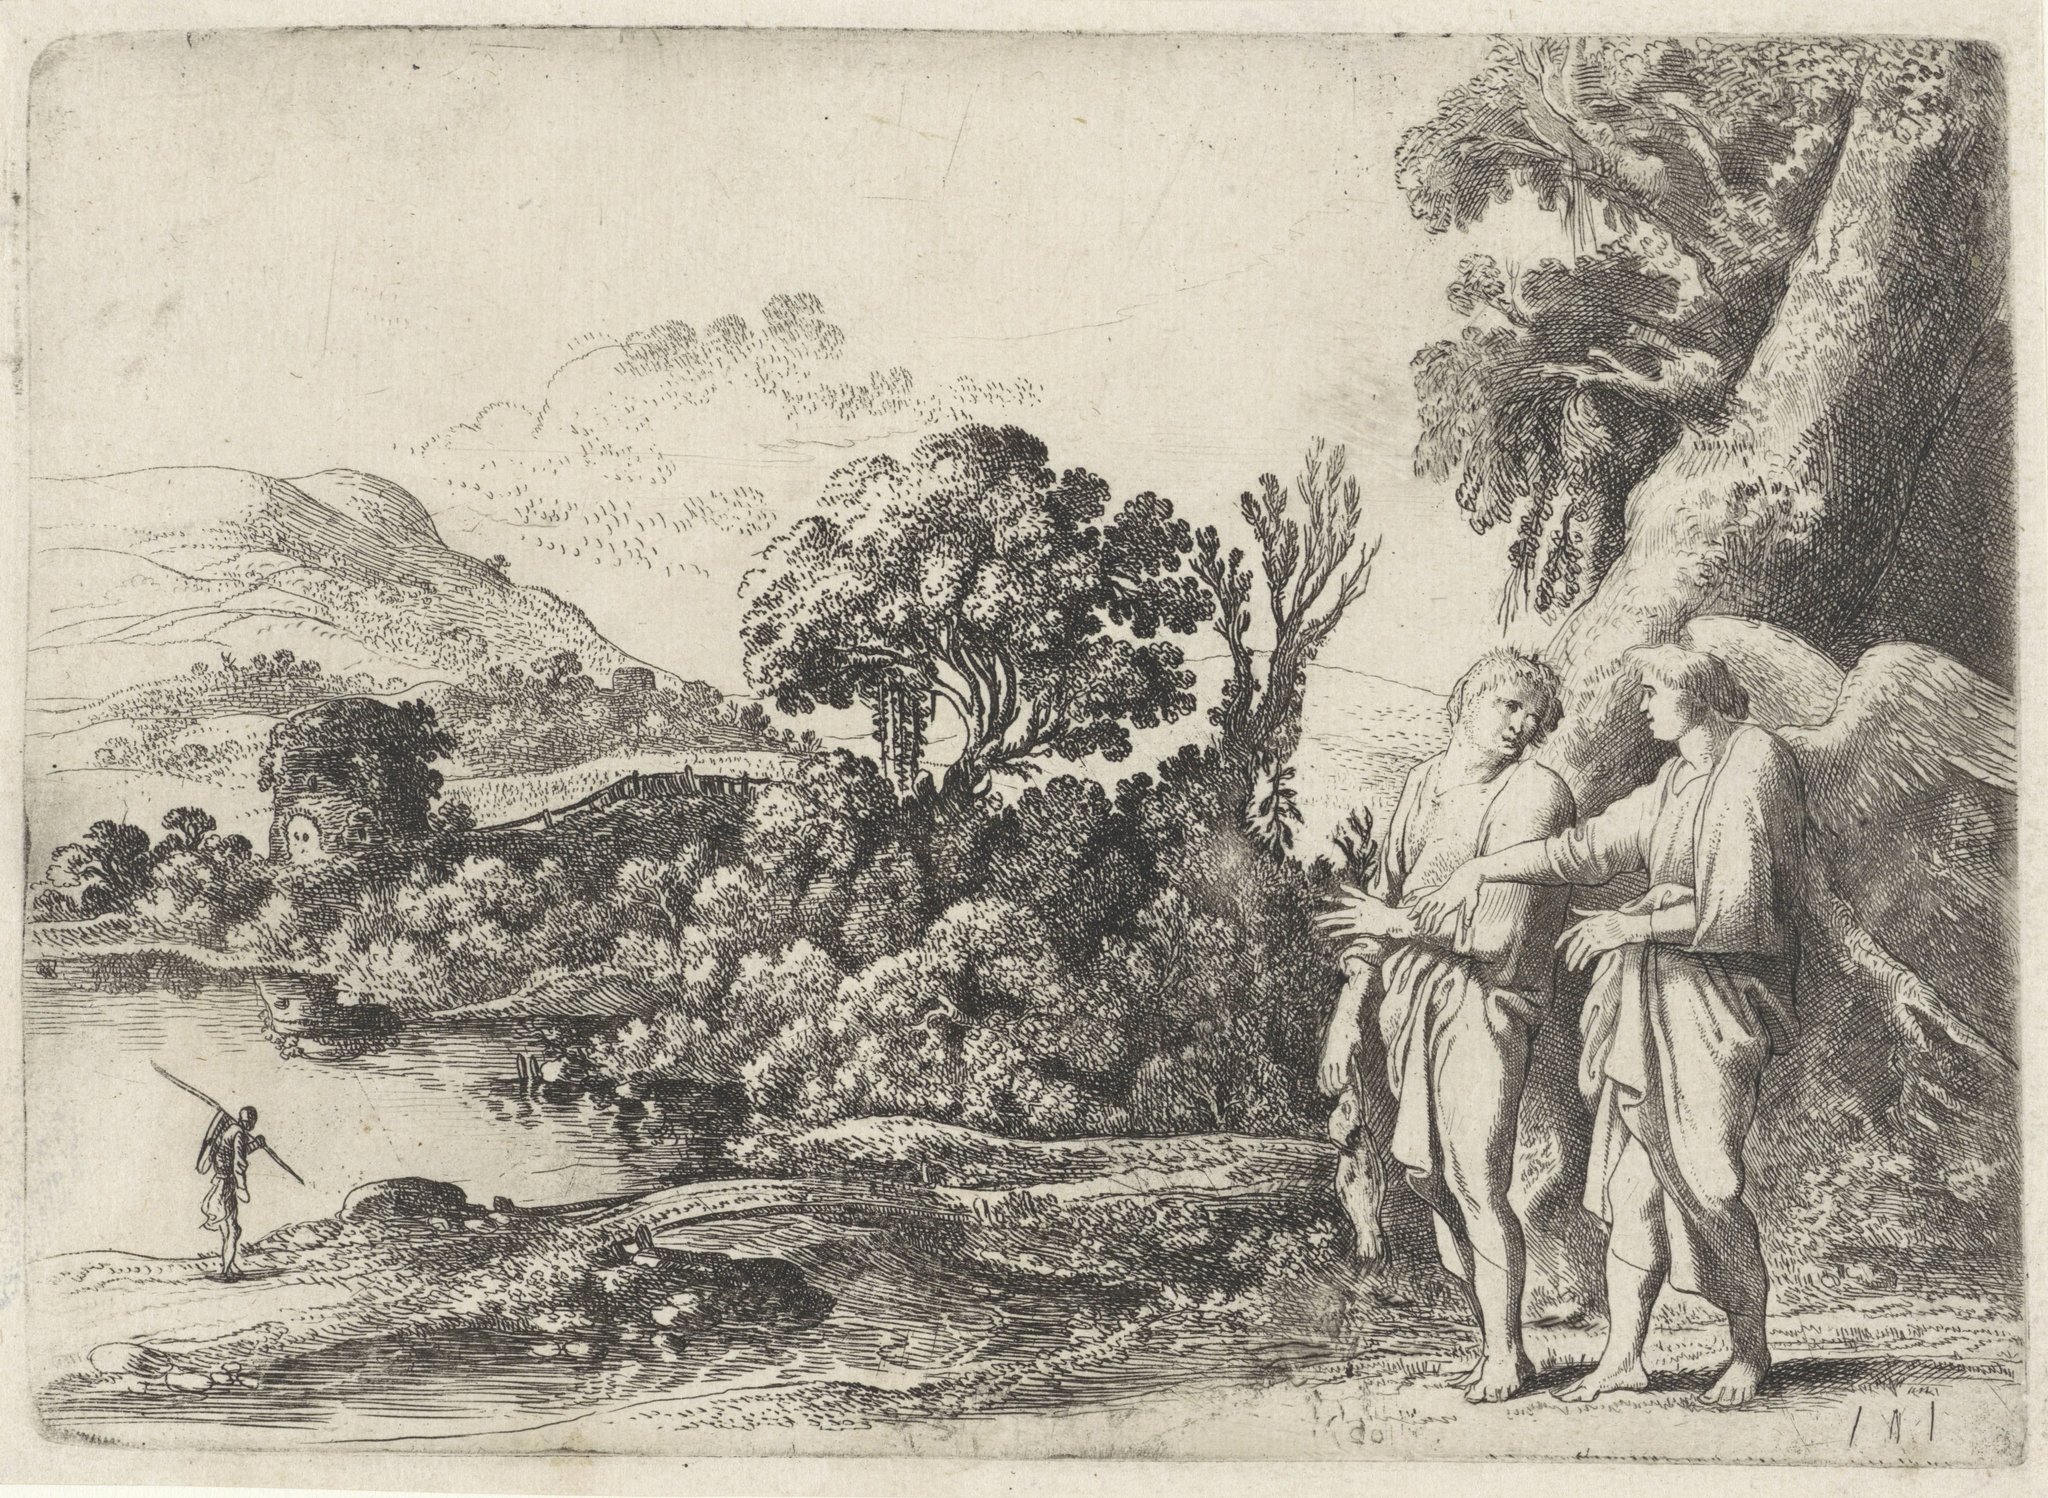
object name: print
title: Tobias en de engel onderweg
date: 1620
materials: paper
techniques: engraving, etching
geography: the hague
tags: tobias and the angel raphael continue their journey; usually tobias carrying the fish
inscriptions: collector's mark: Lugt 240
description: De engel strekt zijn arm uit naar Tobias, die de vis draagt. Genummerd als III.